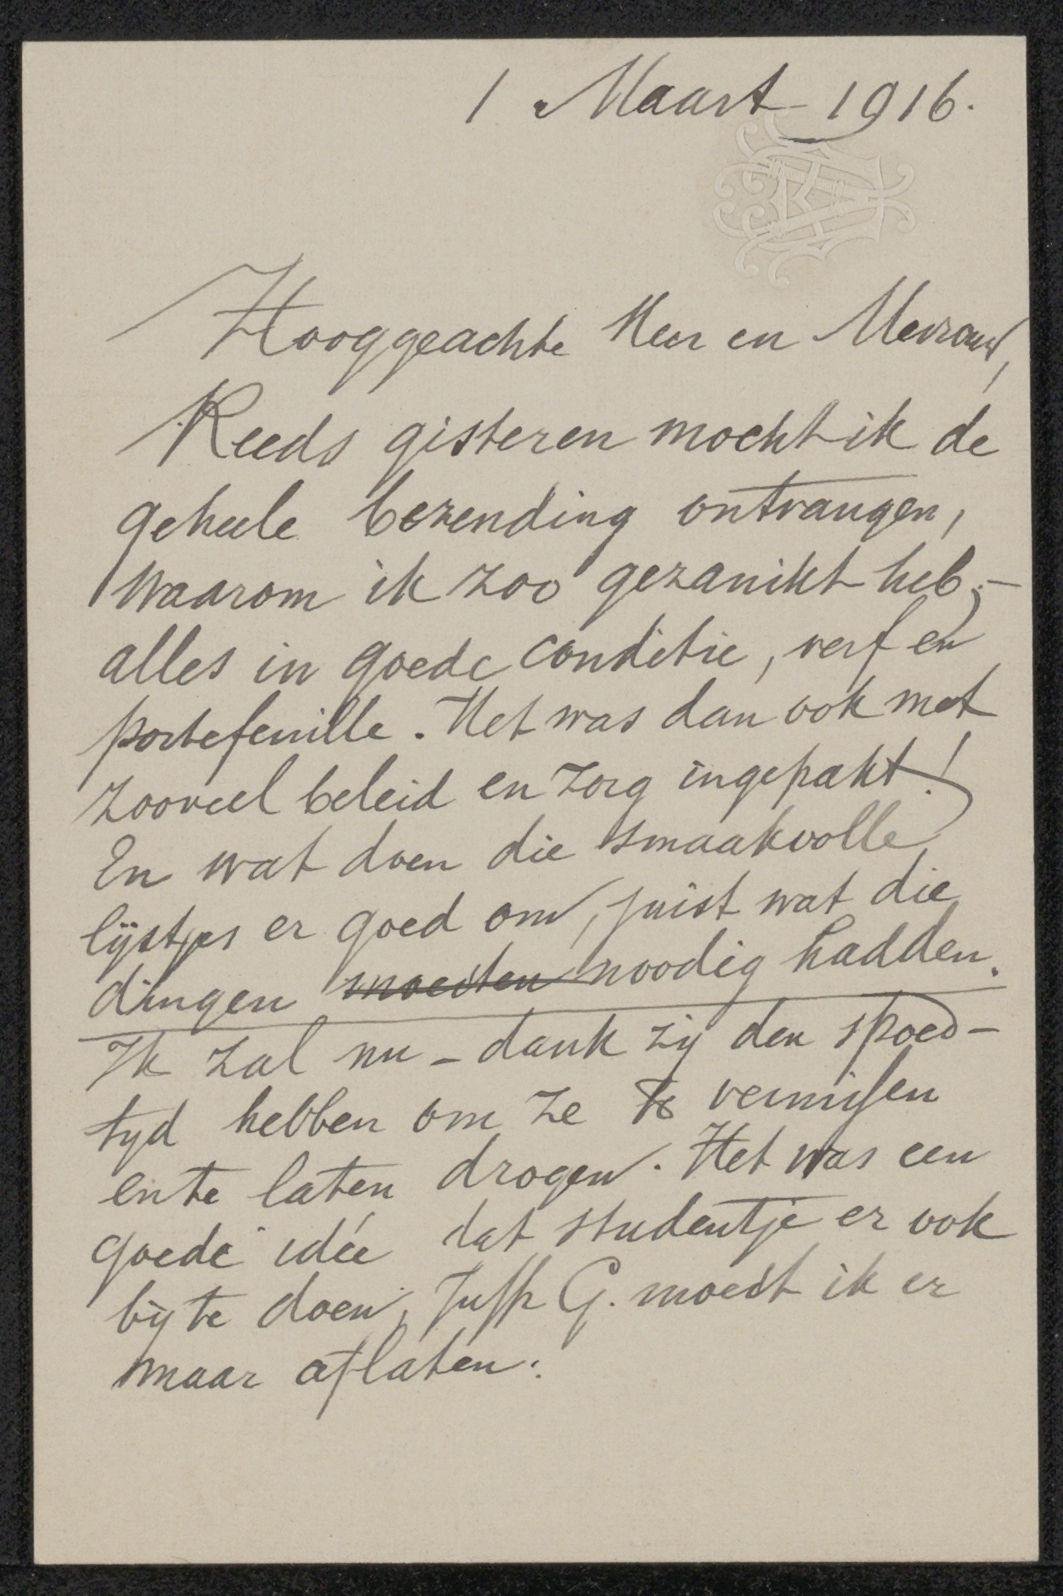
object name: letter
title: Brief aan Max Wilhelm Carl Weber en Anne Antoinette Weber-Van Bosse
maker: august allebé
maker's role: draughtsman, print maker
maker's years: 1838-1927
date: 1916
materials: cardboard, ink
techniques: pen, writing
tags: anne antoinette weber-van bosse, drawing, painting (including book-illumination, miniature-painting)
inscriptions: monogram: ‘AA’